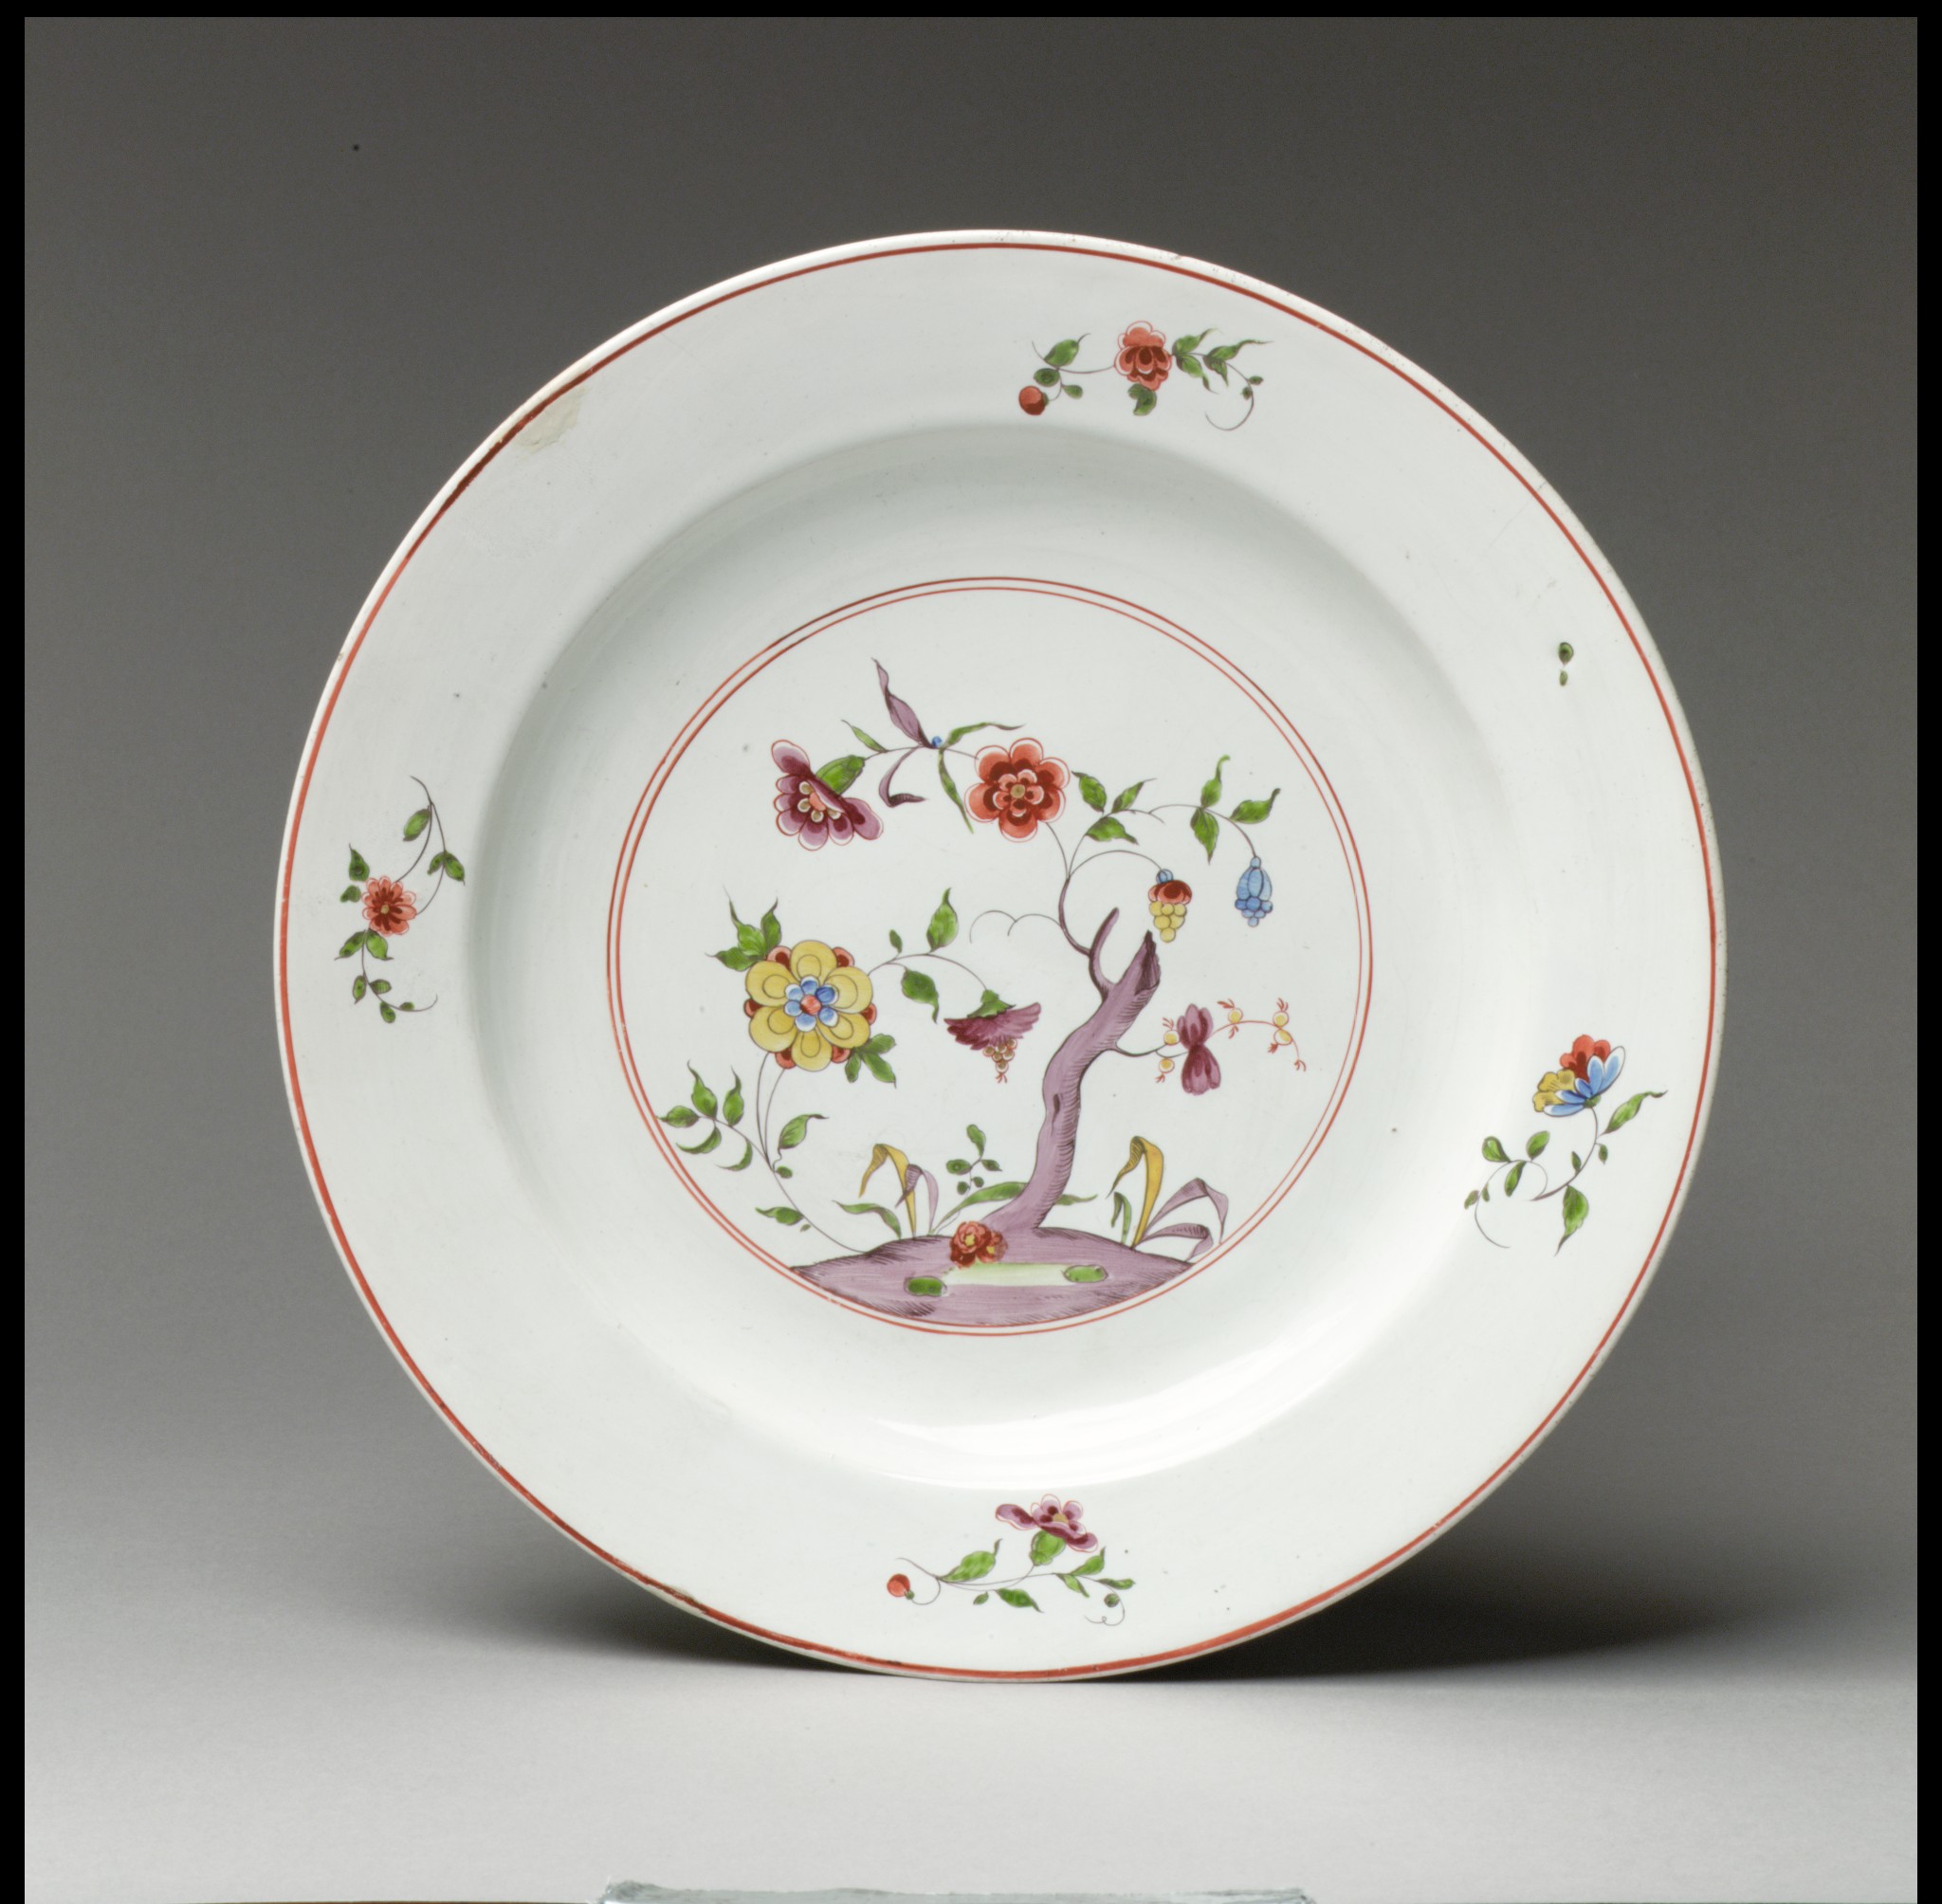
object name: plate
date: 1770-1780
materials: earthenware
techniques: glazing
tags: flowers